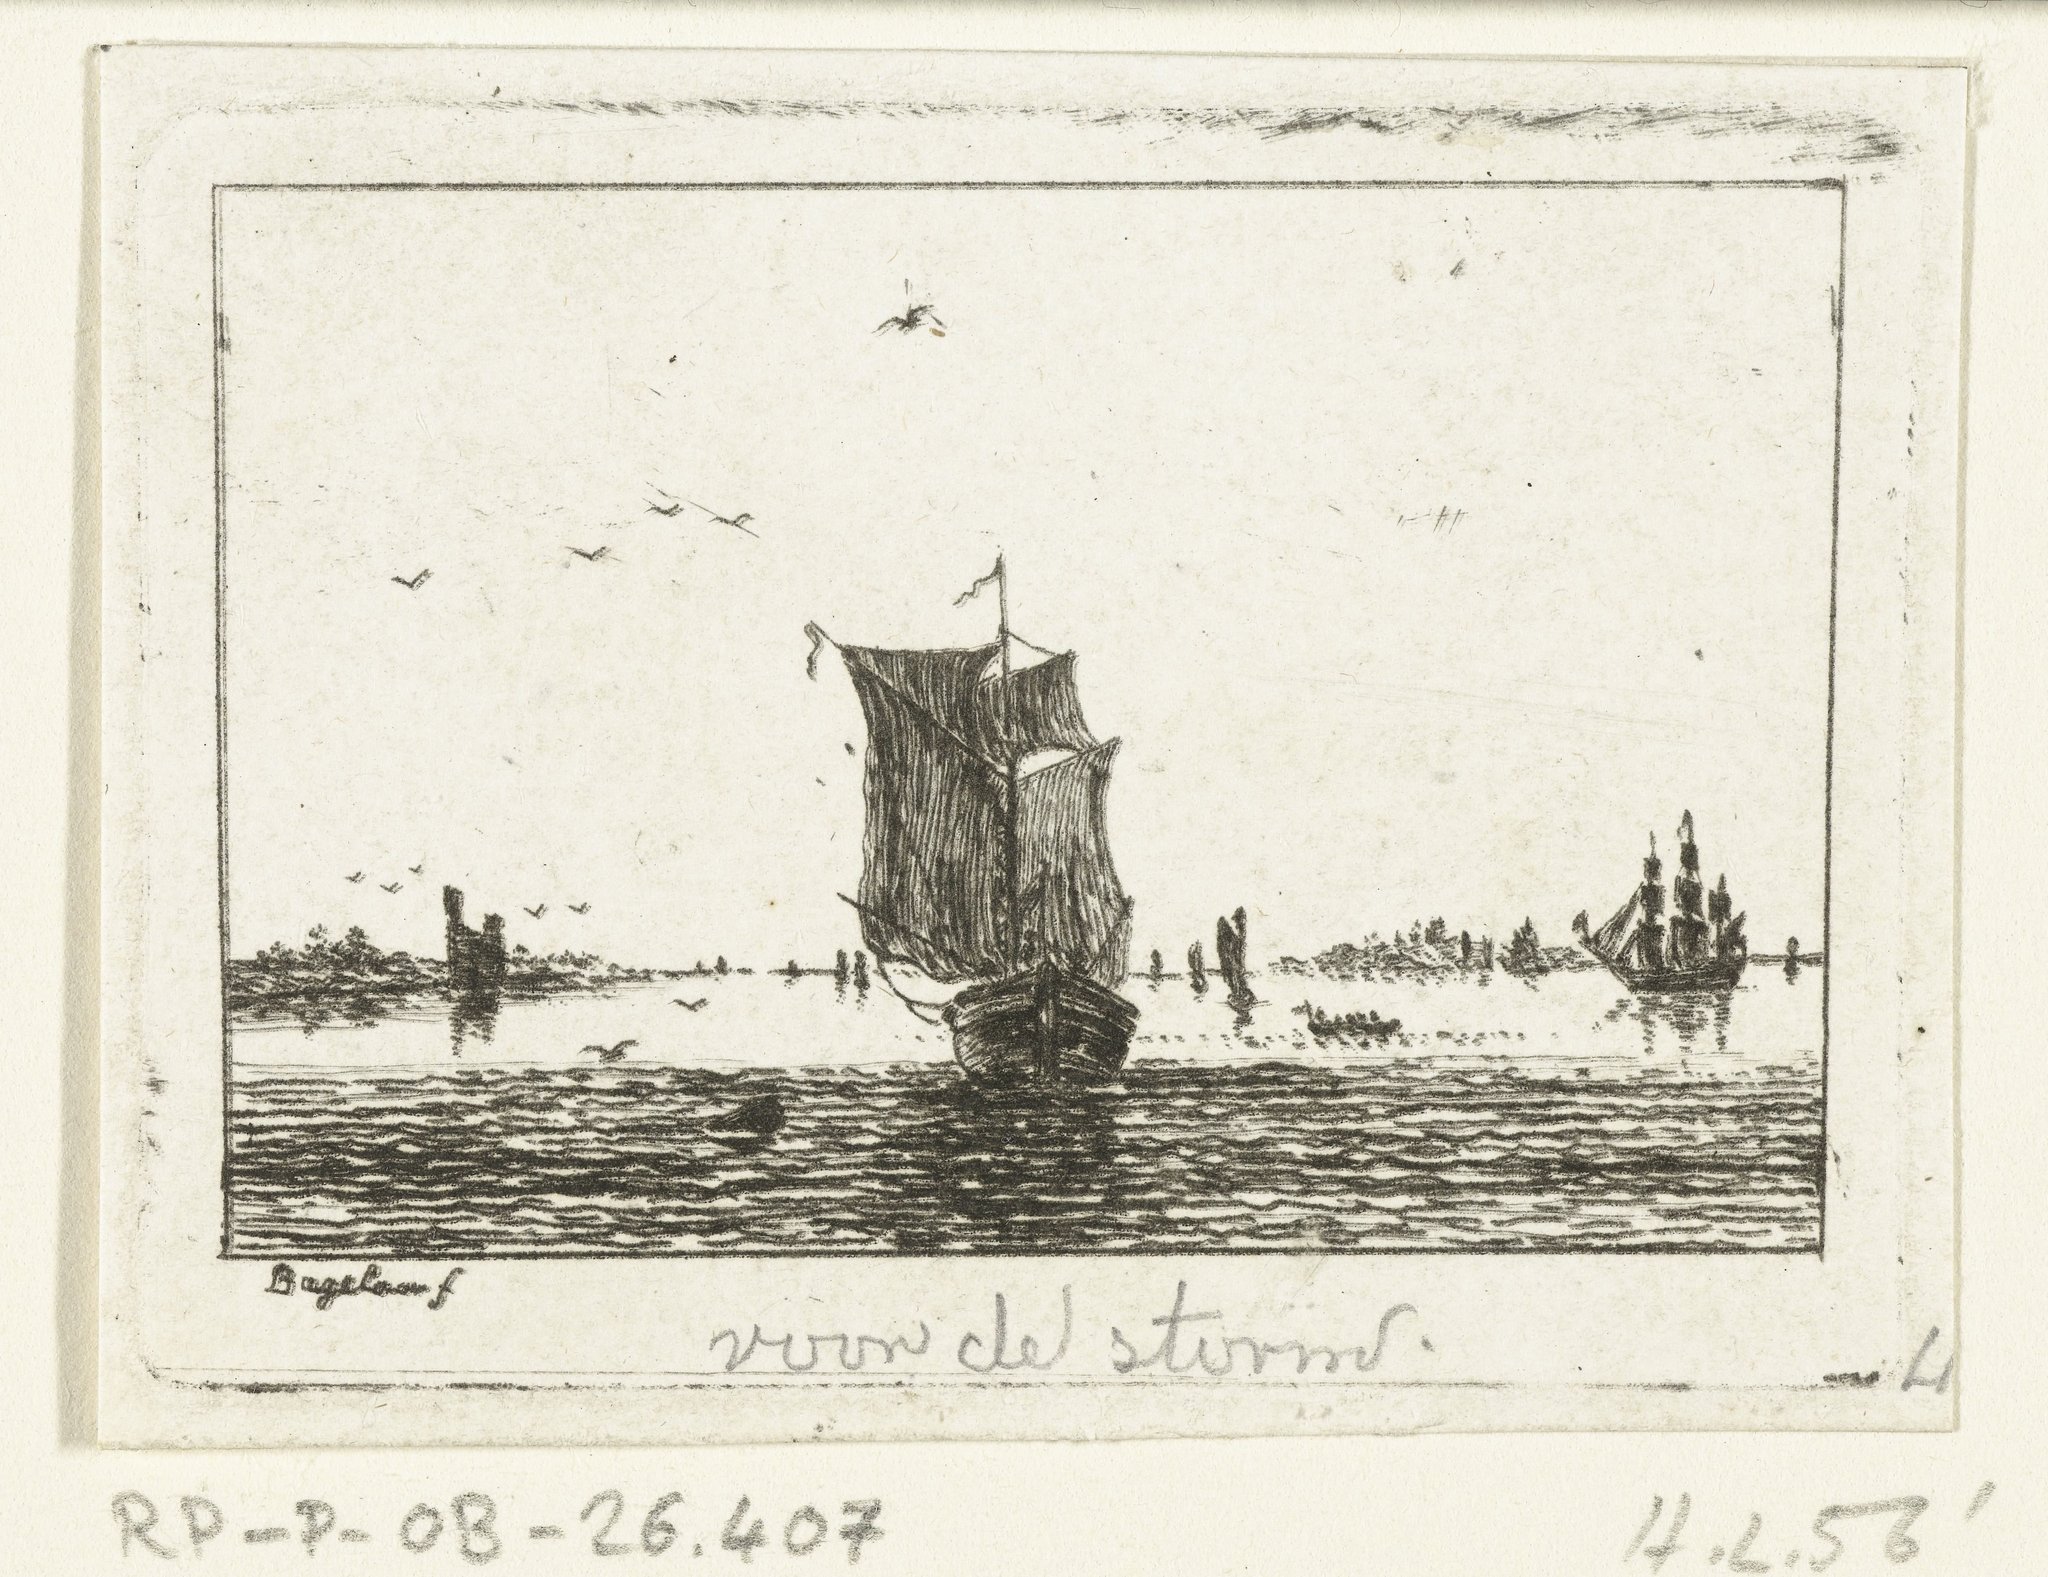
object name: print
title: Waterlandschap met zeilschip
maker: ernst willem jan bagelaar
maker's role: draughtsman, print maker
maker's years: 1775-1837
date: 1798-1837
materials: paper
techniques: etching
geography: netherlands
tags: landscapes with waters, waterscapes, seascapes (in the temperate zone)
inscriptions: inscription: ‘voor de storm’